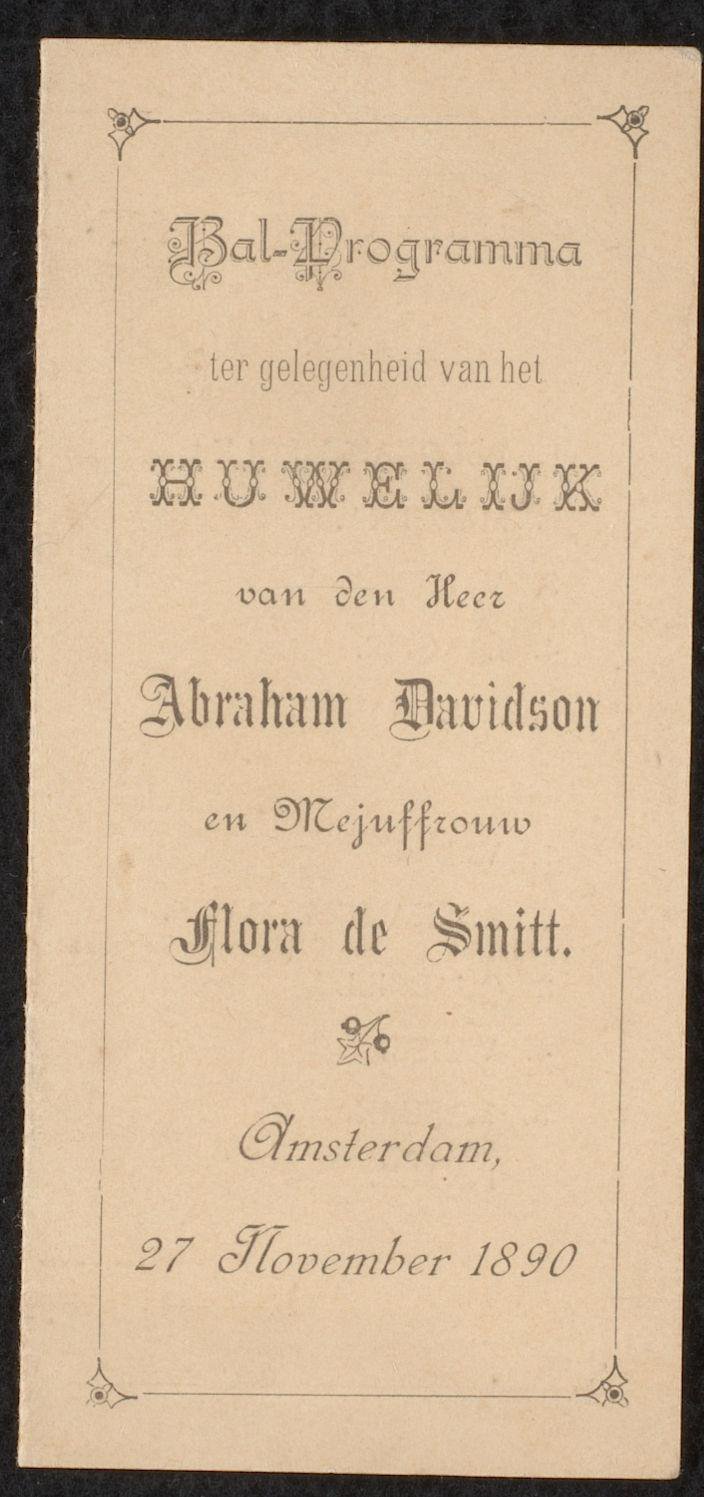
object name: dance card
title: Balboekje voor het huwelijk van Abraham Davidson en Flora de Smitt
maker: Anonymous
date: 1890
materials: paper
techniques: letterpress printing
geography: amsterdam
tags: haarlem, wedding feast, wedding meal, ball, formal dance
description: Op de voorzijde: 'Bal-Programma ter gelegenheid van het huwelijk van den Heer Abraham Davidson en Mejuffrouw Flora de Smitt. Amsterdam, 27 november 1890'. Binnenin de (oningevulde) lijst van tien dansen.